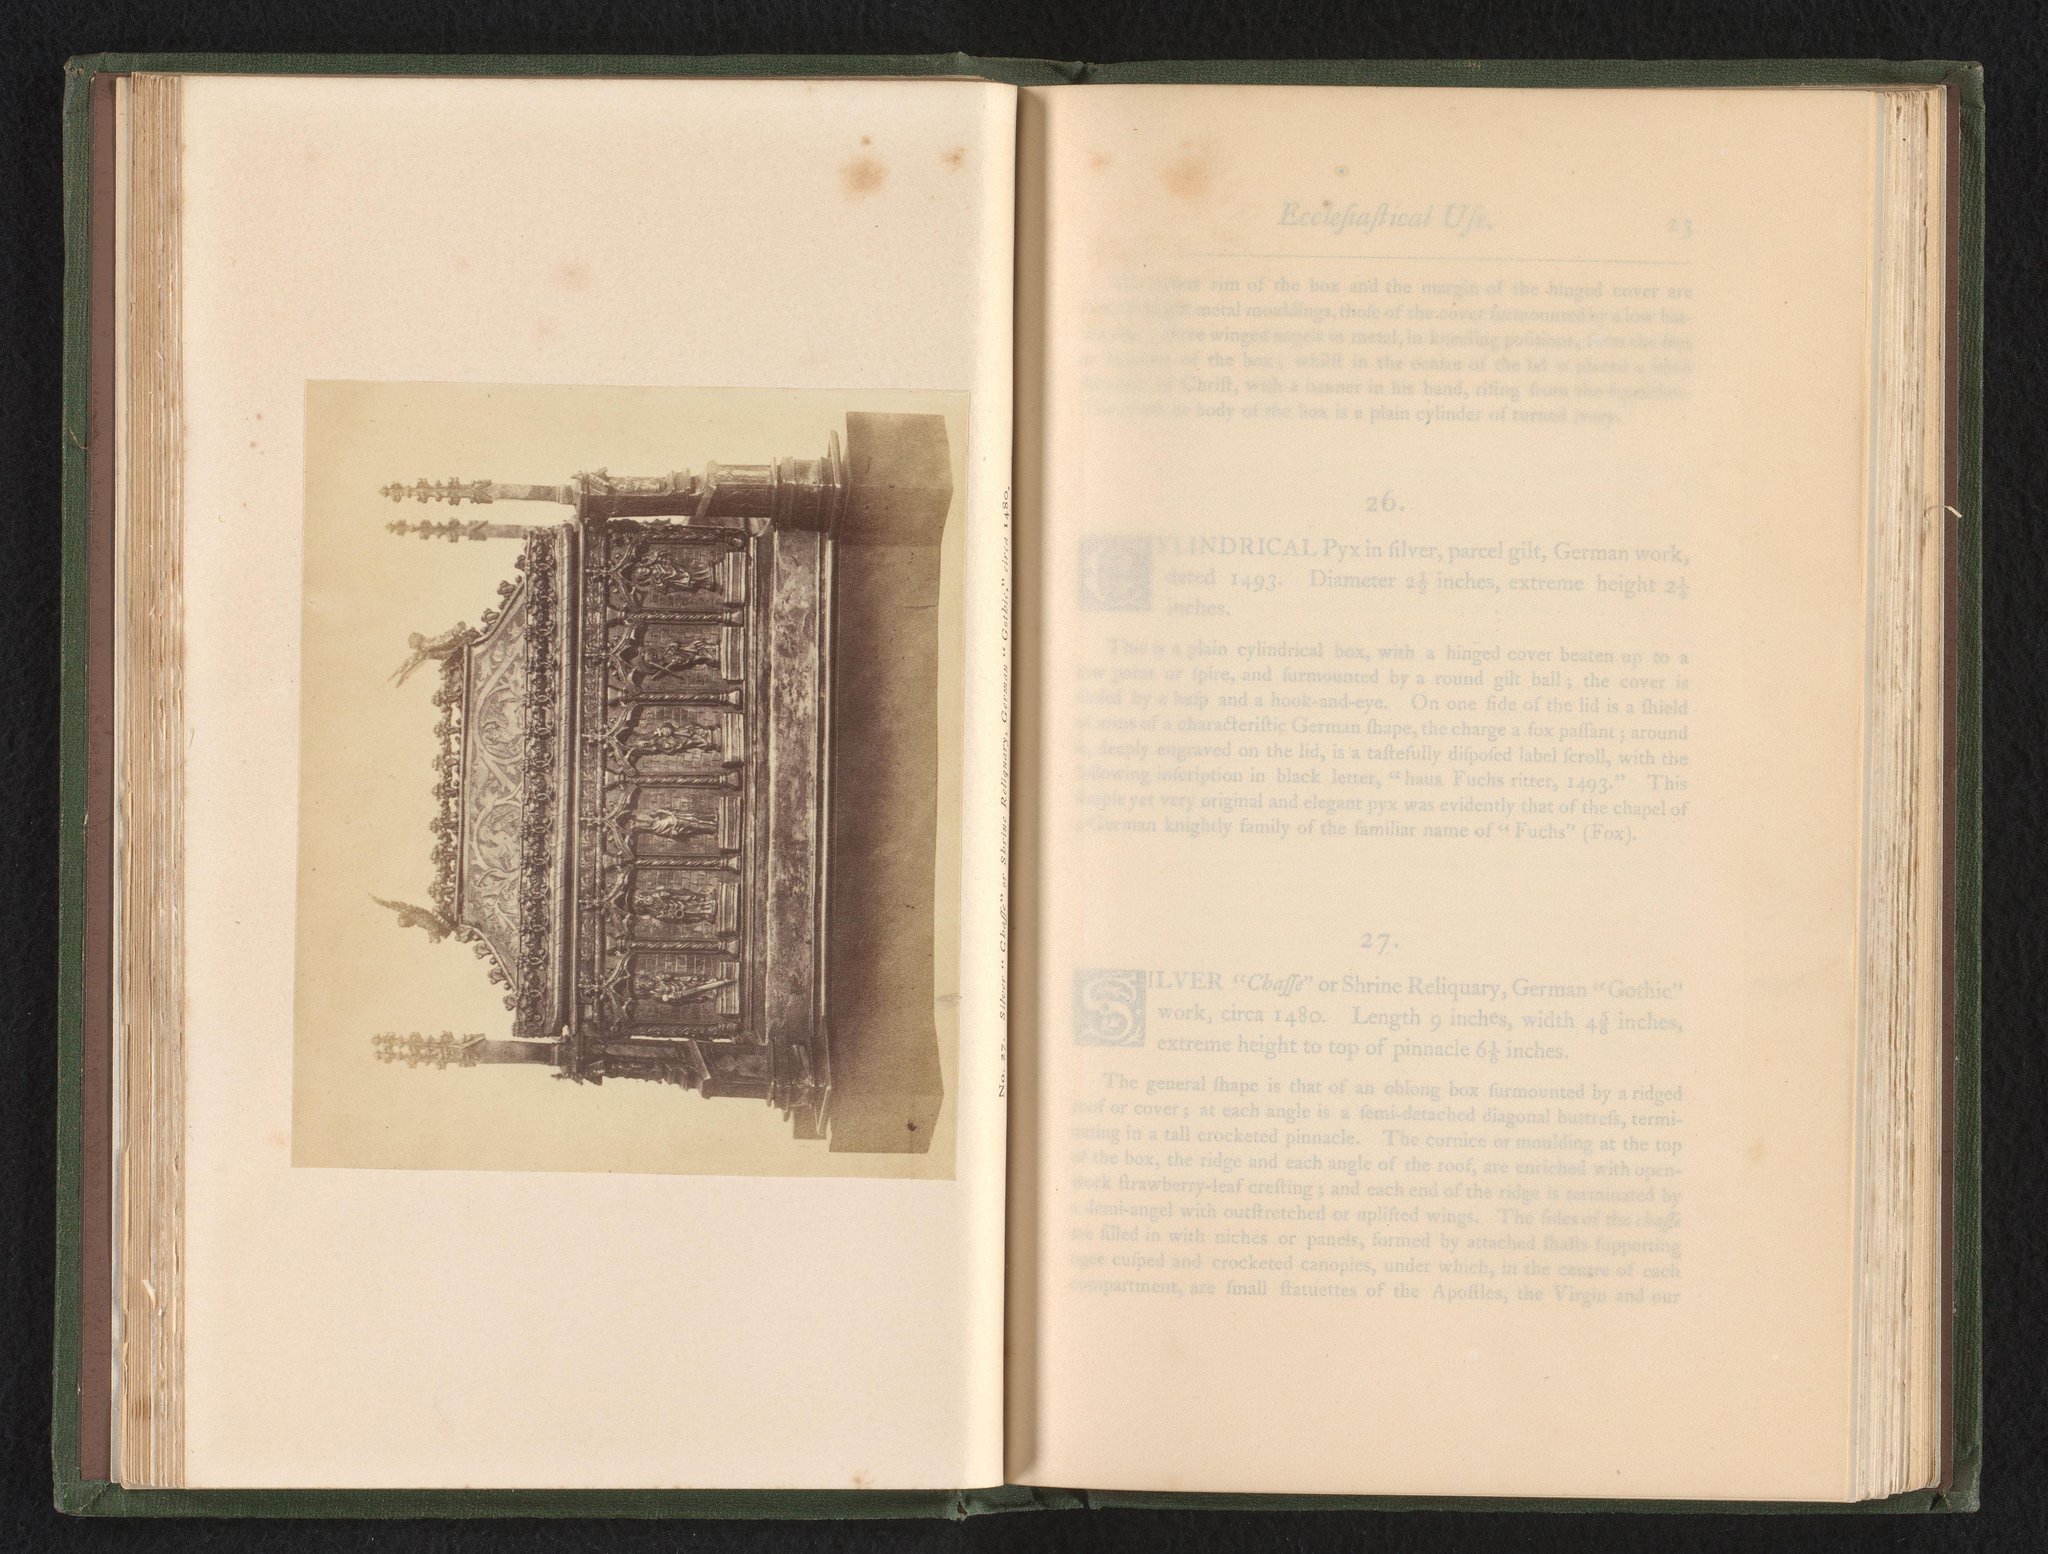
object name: page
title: Silver "Chasse" or Shrine Reliquary, Germain "Gothic", circa 1480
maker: Anonymous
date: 1851-1861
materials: paper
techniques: albumen print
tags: relics (and reliquaries)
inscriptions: number: ‘No. 27.’